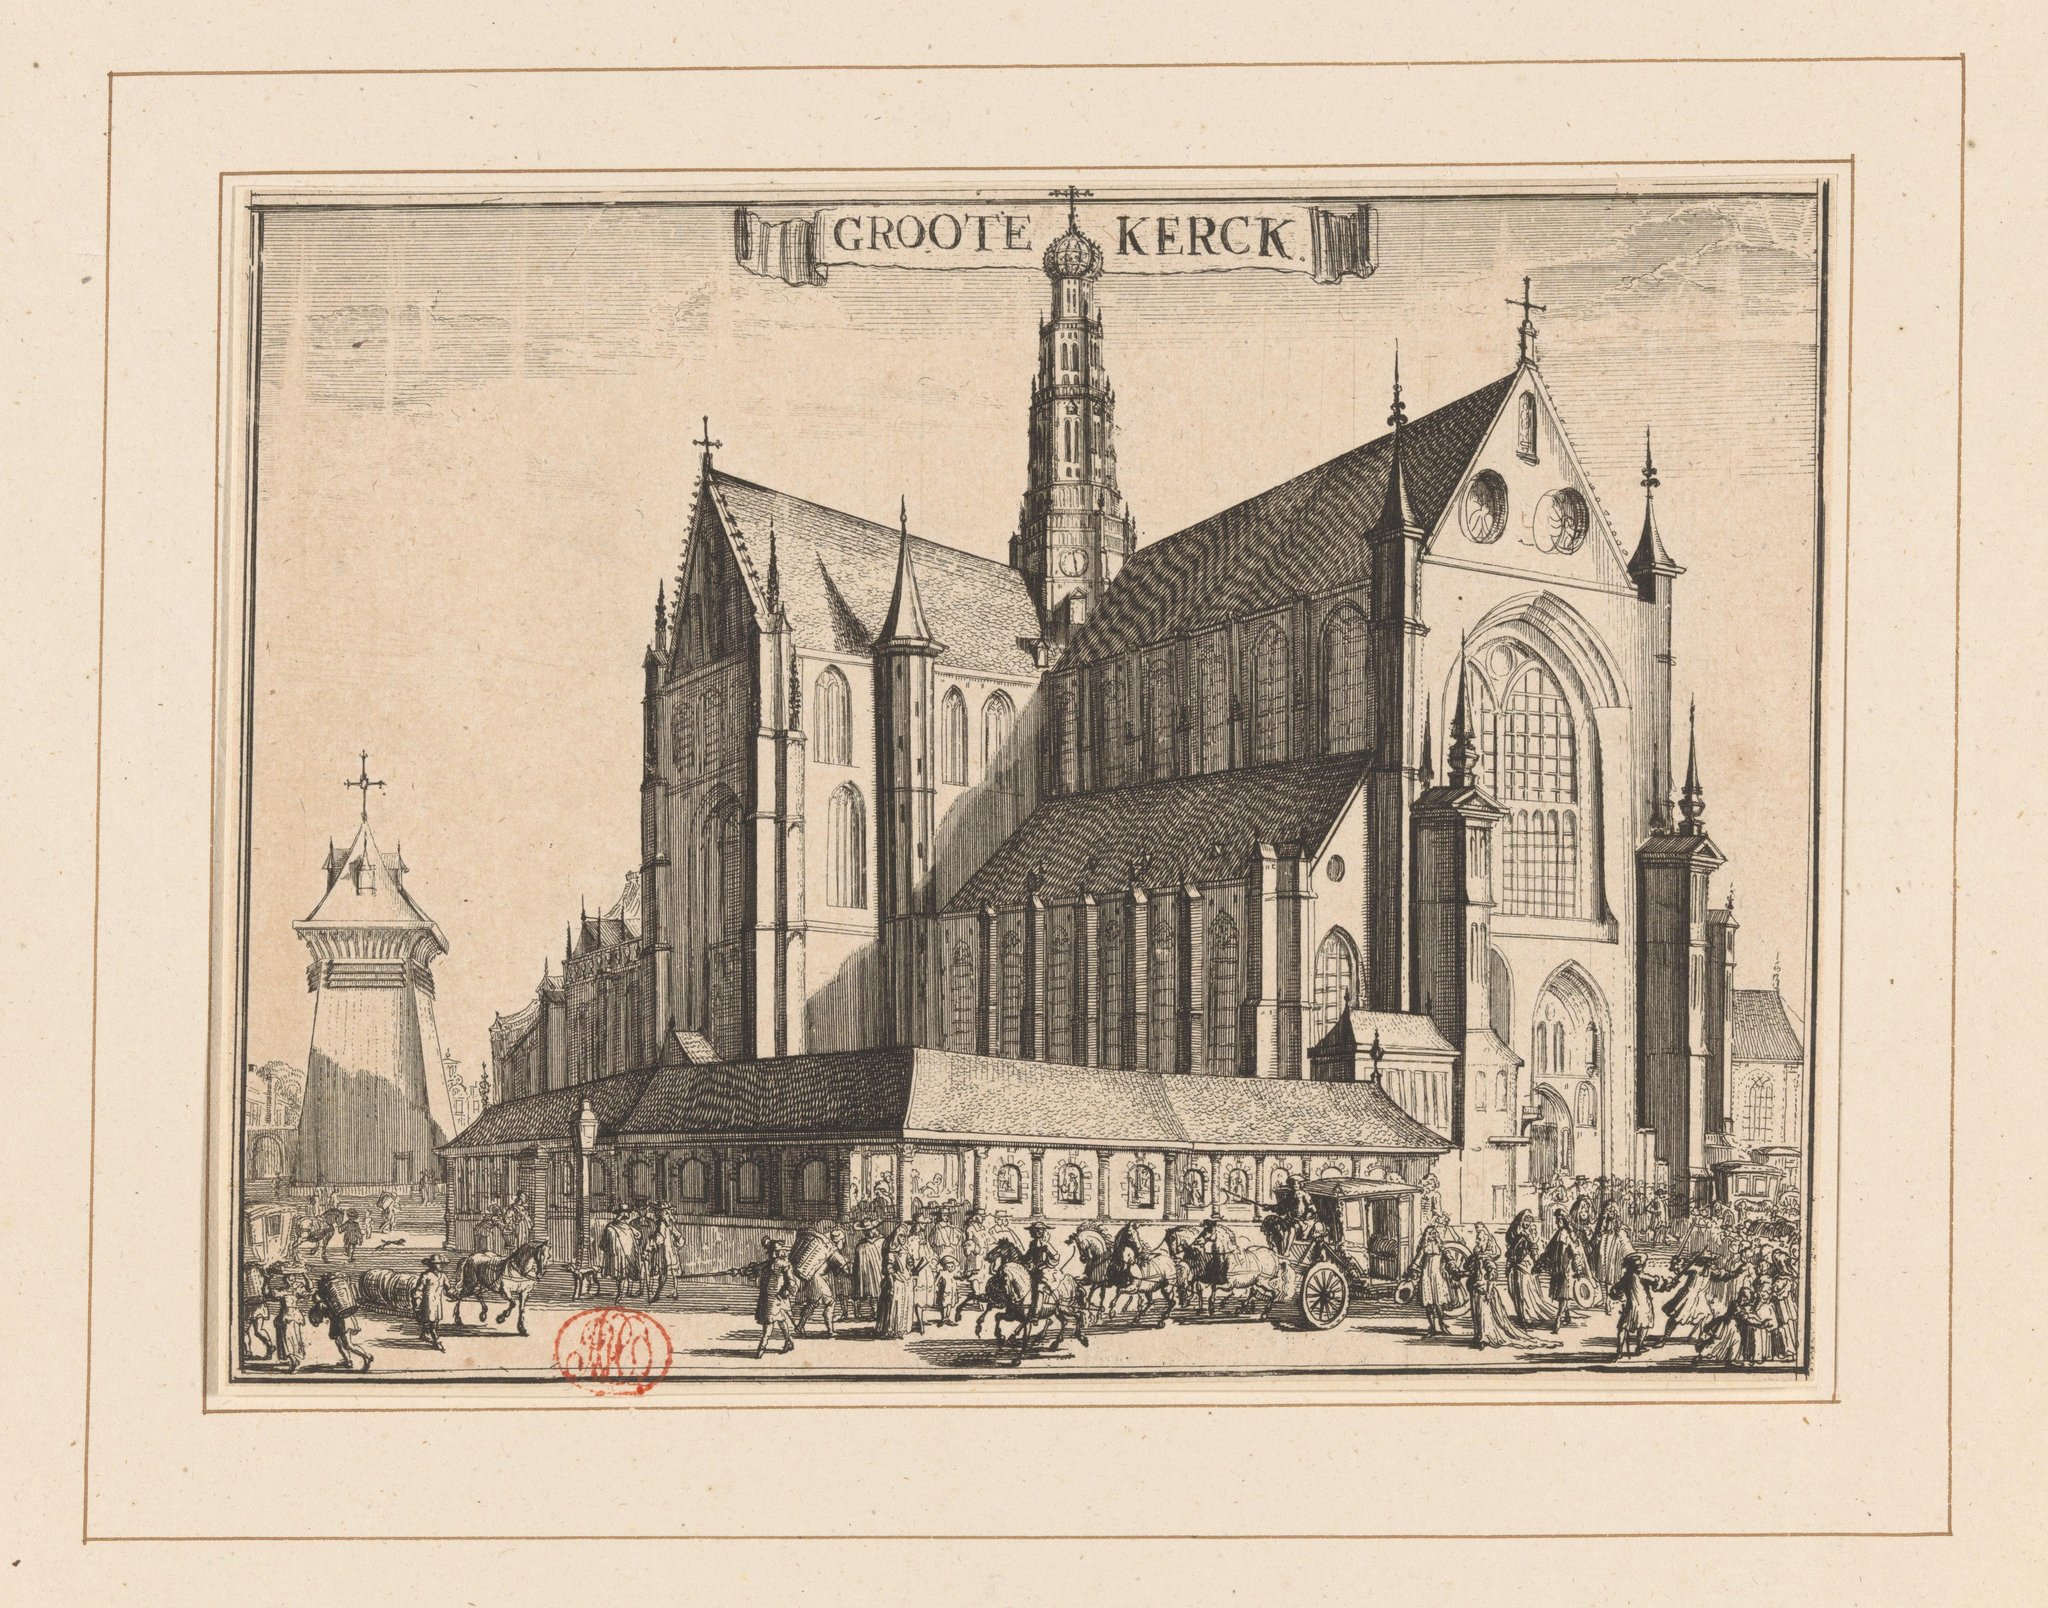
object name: print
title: Groote Kerck.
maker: romeyn de hooghe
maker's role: draughtsman, goldsmith, painter, print maker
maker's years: 1645-1708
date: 1688-1689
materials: paper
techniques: etching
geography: haarlem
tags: church (exterior)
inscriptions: collector's mark: Lugt 195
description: Gezicht op de Grote of Sint-Bavokerk te Haarlem, met vele mensen en enkele koetsen op het plein (de Grote Markt) ervoor. Dit blad maakt oorspronkelijk deel uit van een omvangrijke prent met een grote plattegrond van Haarlem, omgeven door zeven wapenschilden, een profiel van de stad, gezichten op markante Haarlemse gebouwen en voorstellingen van belangrijke momenten uit de Haarlemse geschiedenis.